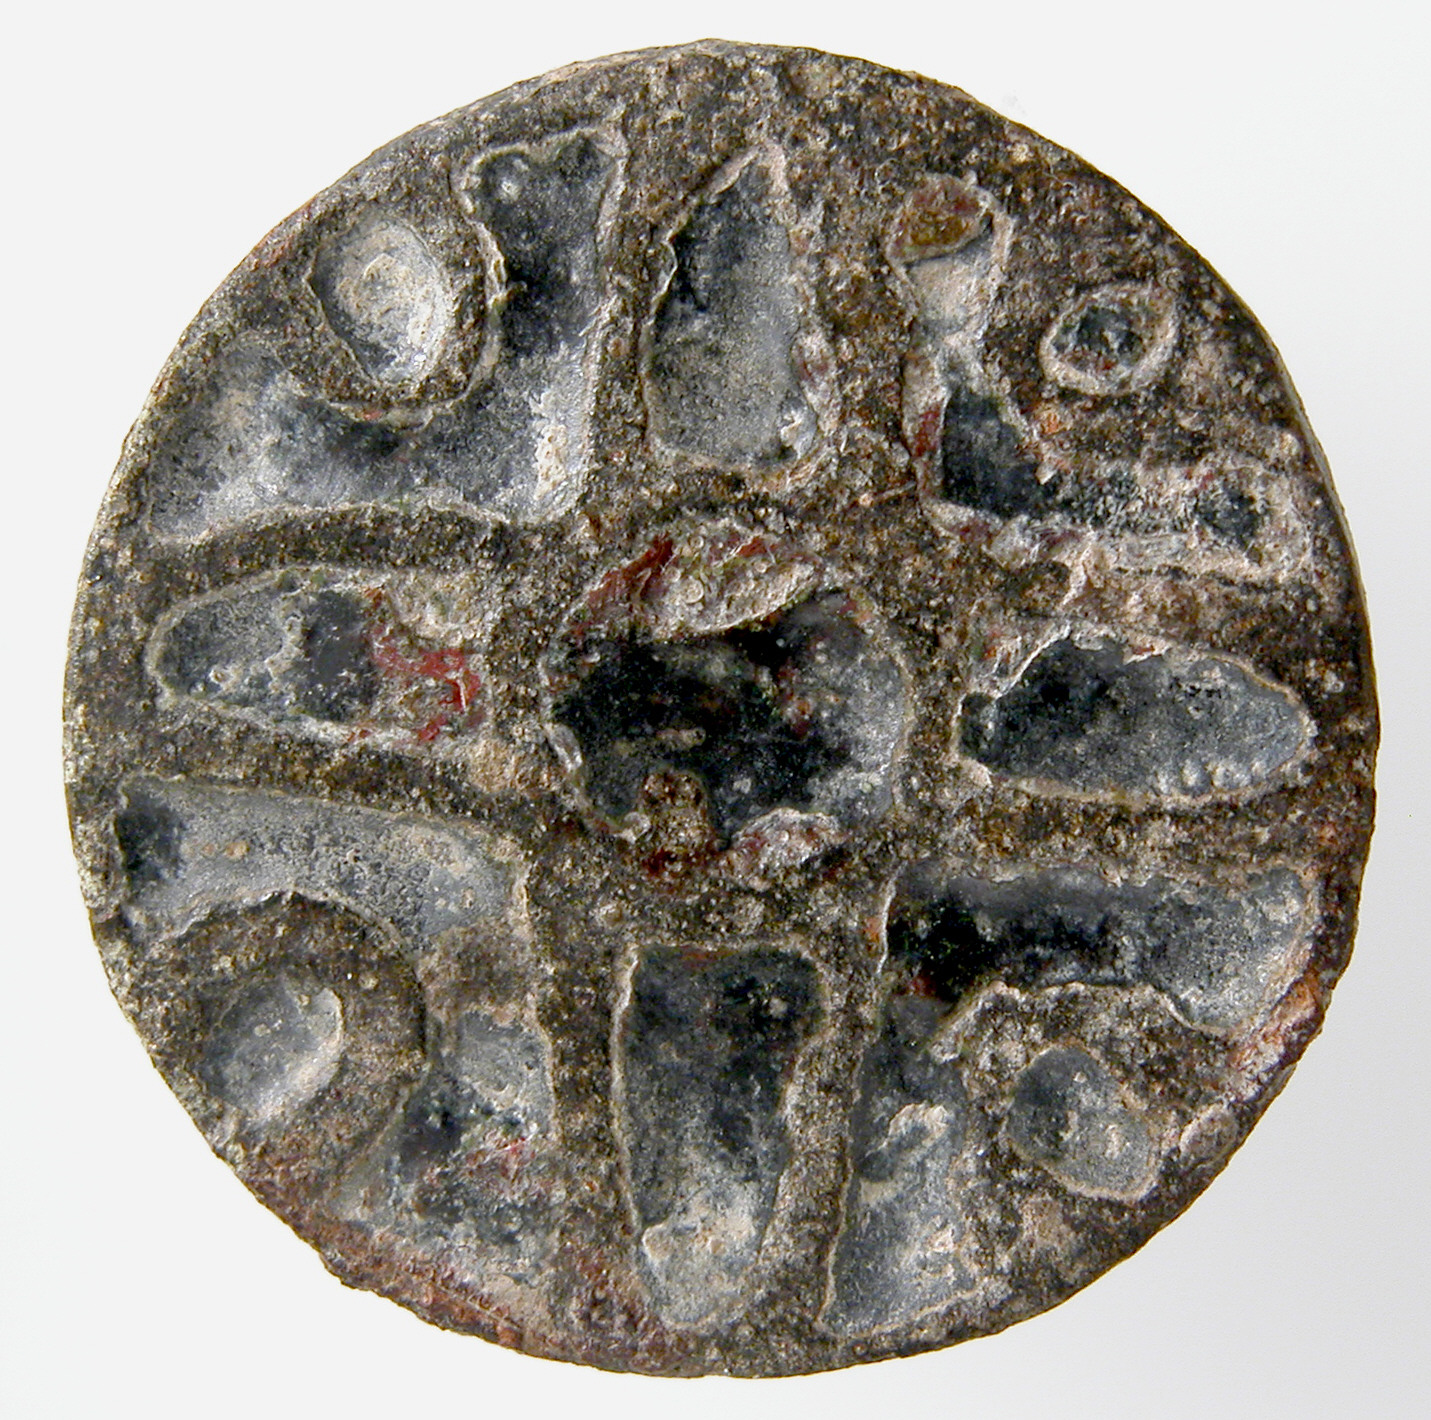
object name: brooch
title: Disk Brooch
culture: merovingian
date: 701-900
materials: copper alloy, enamel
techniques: enamel